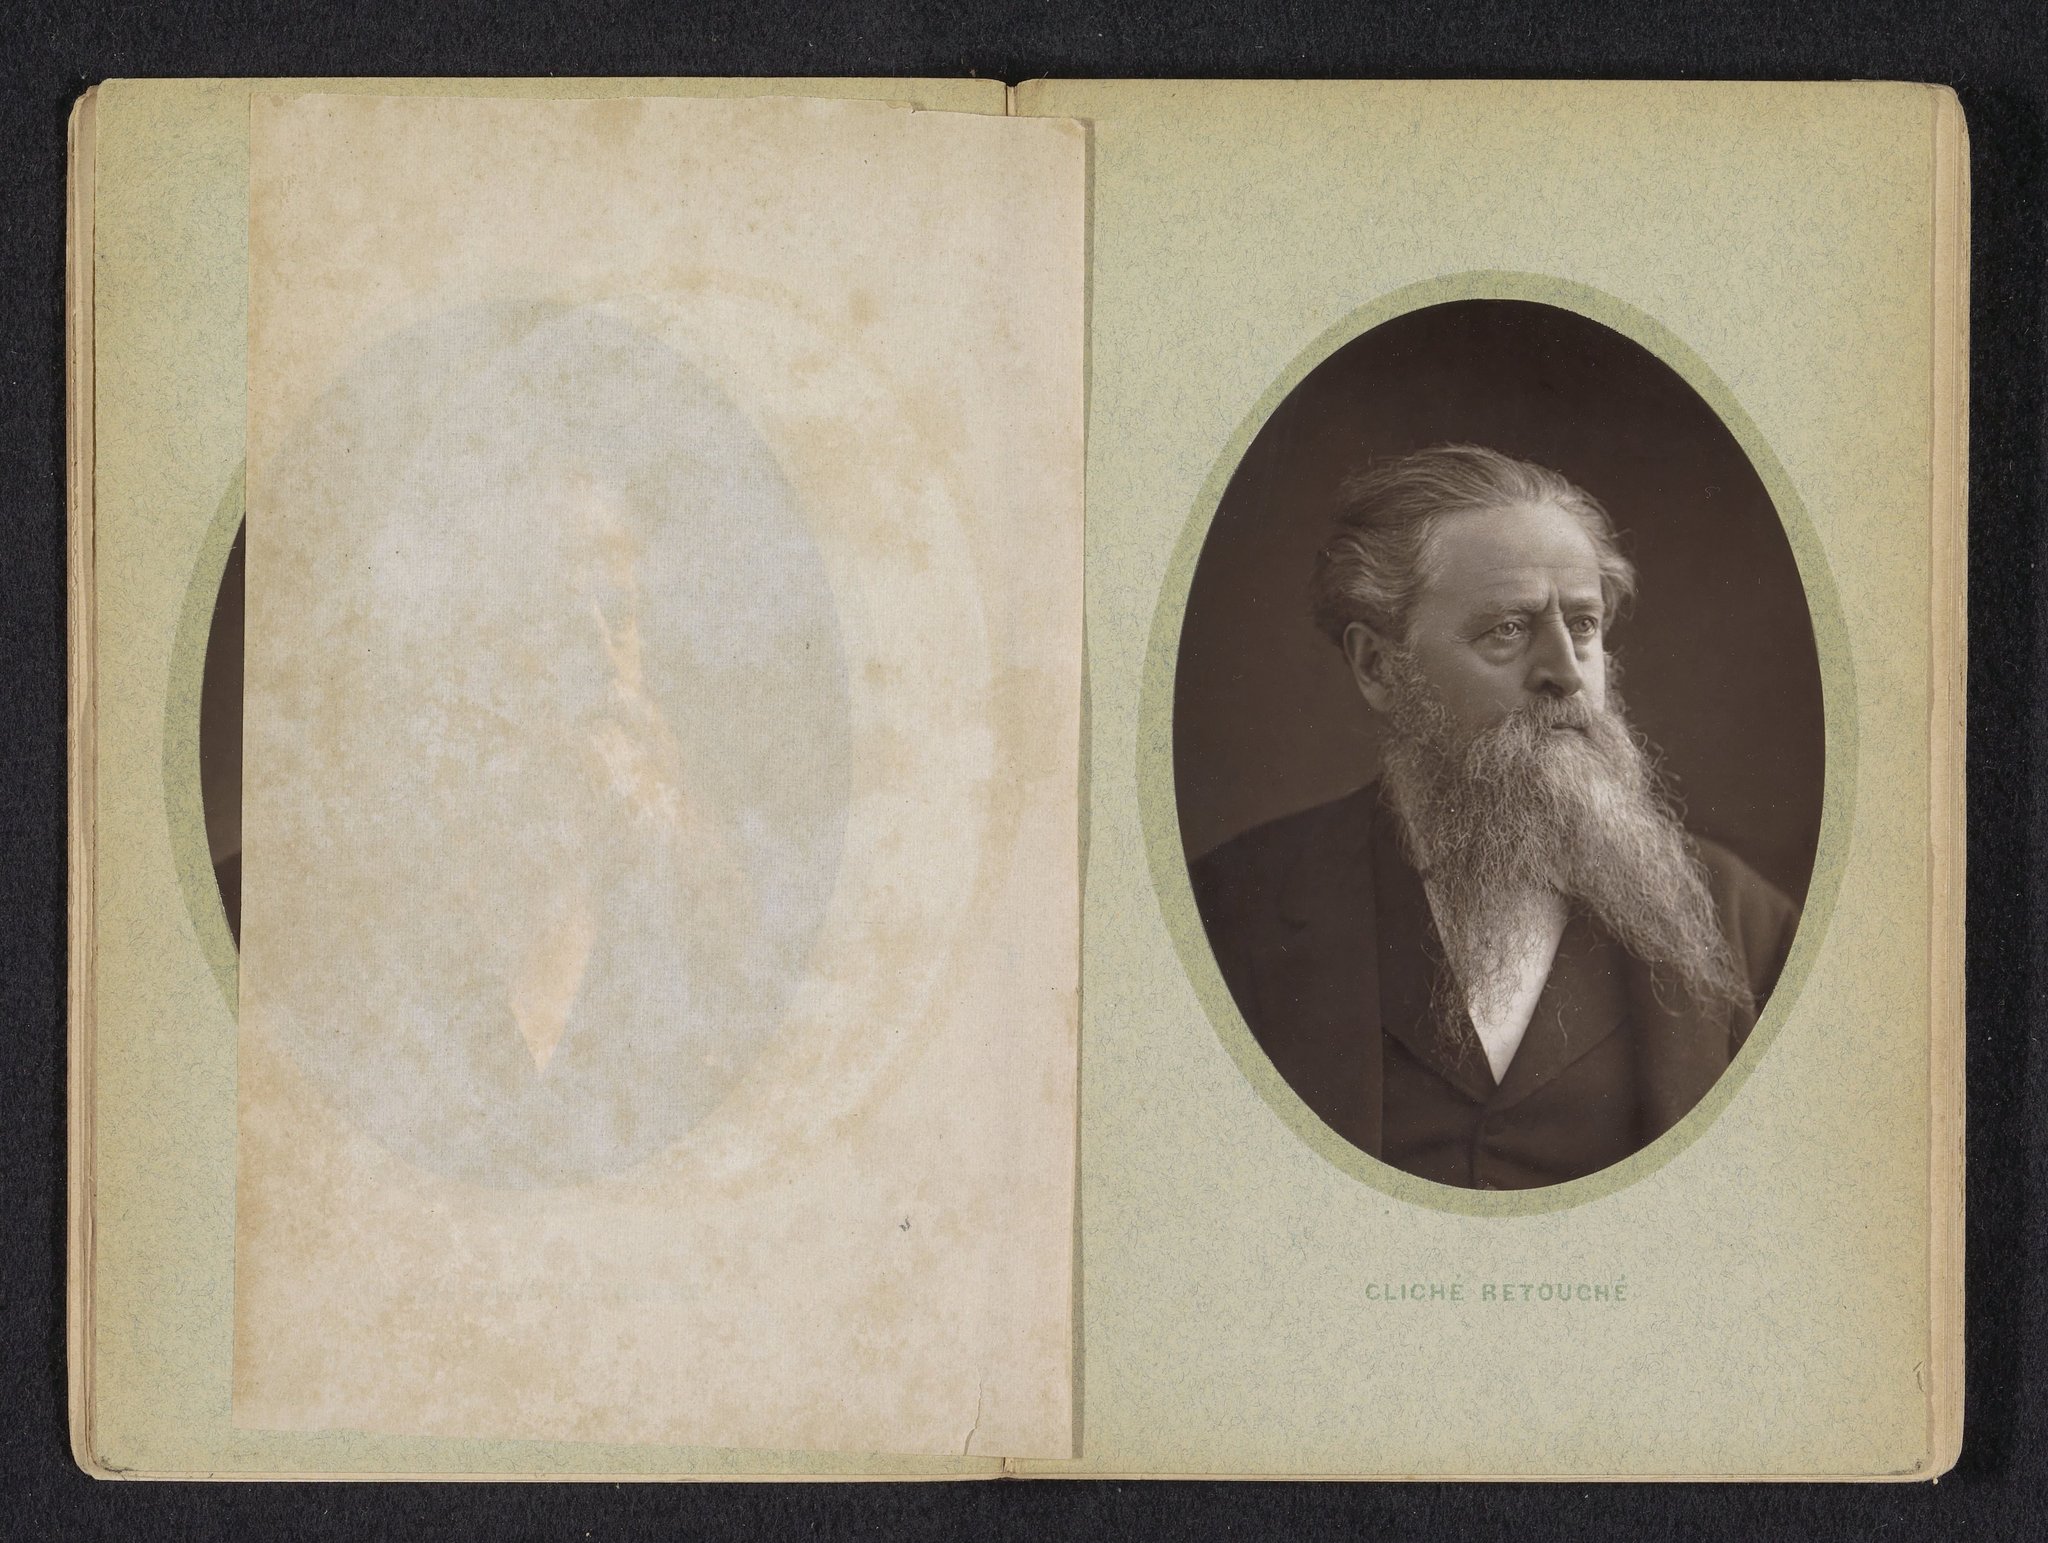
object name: photomechanical print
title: Cliché retouché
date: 1875-1885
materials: paper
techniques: woodburytype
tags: historical persons not known by name (+ (full) bust portrait), beard